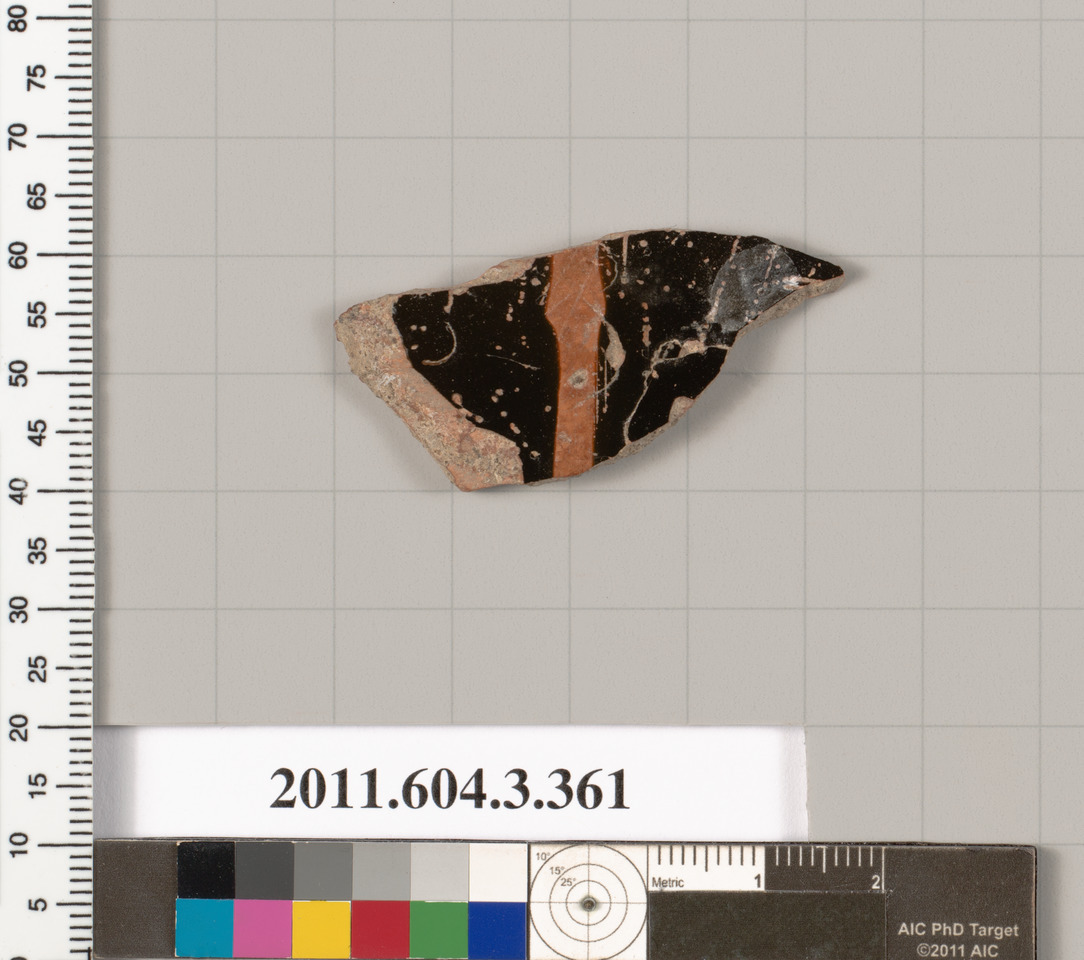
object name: neck amphora fragment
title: Terracotta fragment of a neck-amphora (jar)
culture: greek, attic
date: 525-501 BCE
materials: terracotta